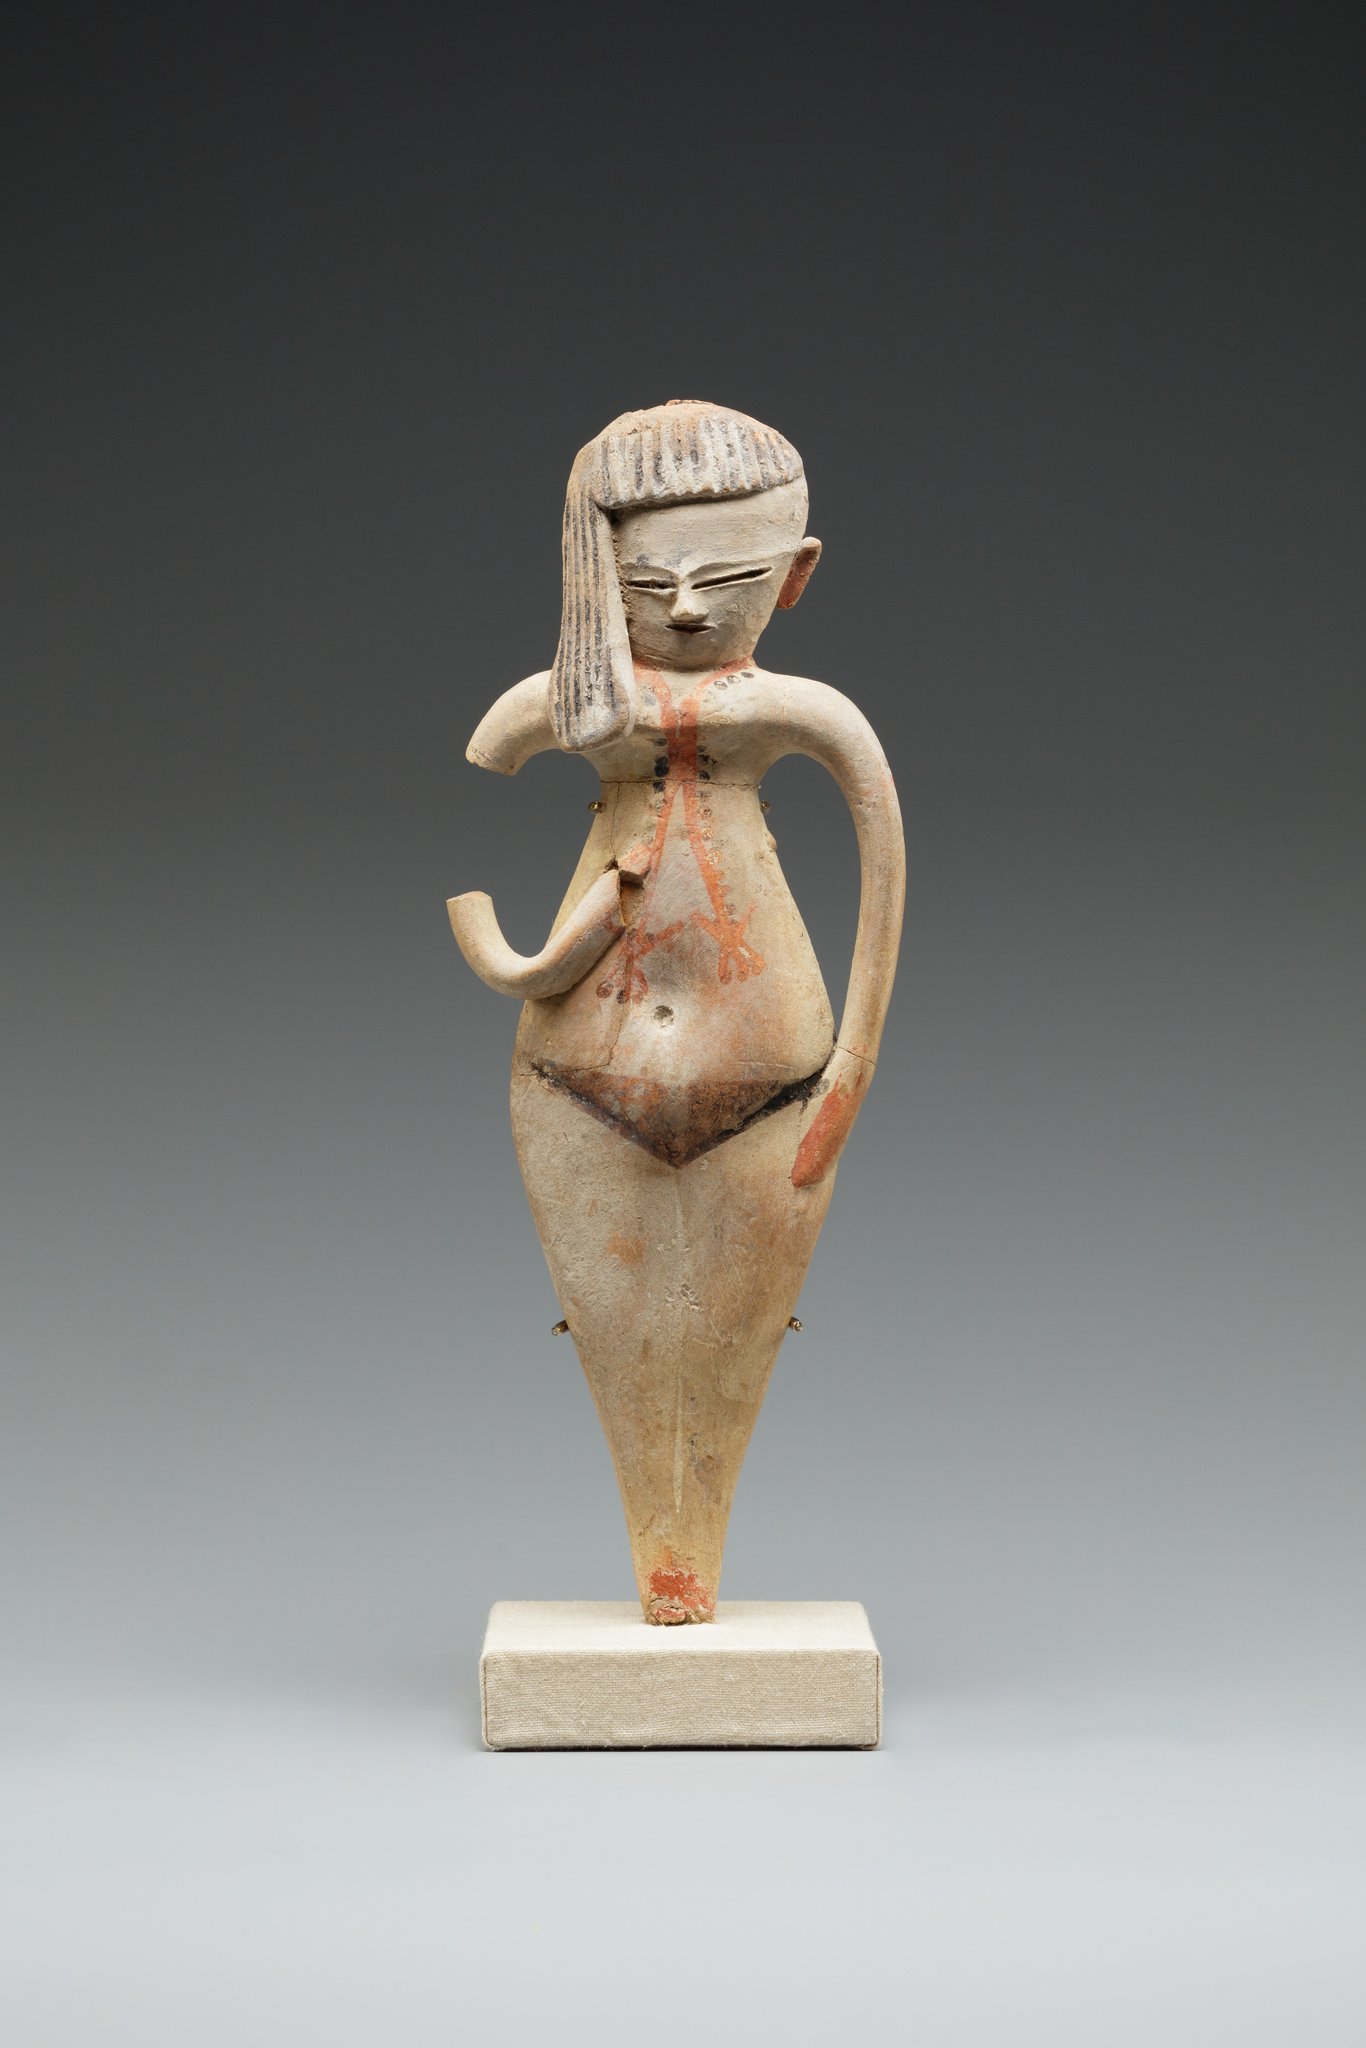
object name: statuette, female nude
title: Statuette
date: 1295-1070 BCE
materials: paint, pottery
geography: egypt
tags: women